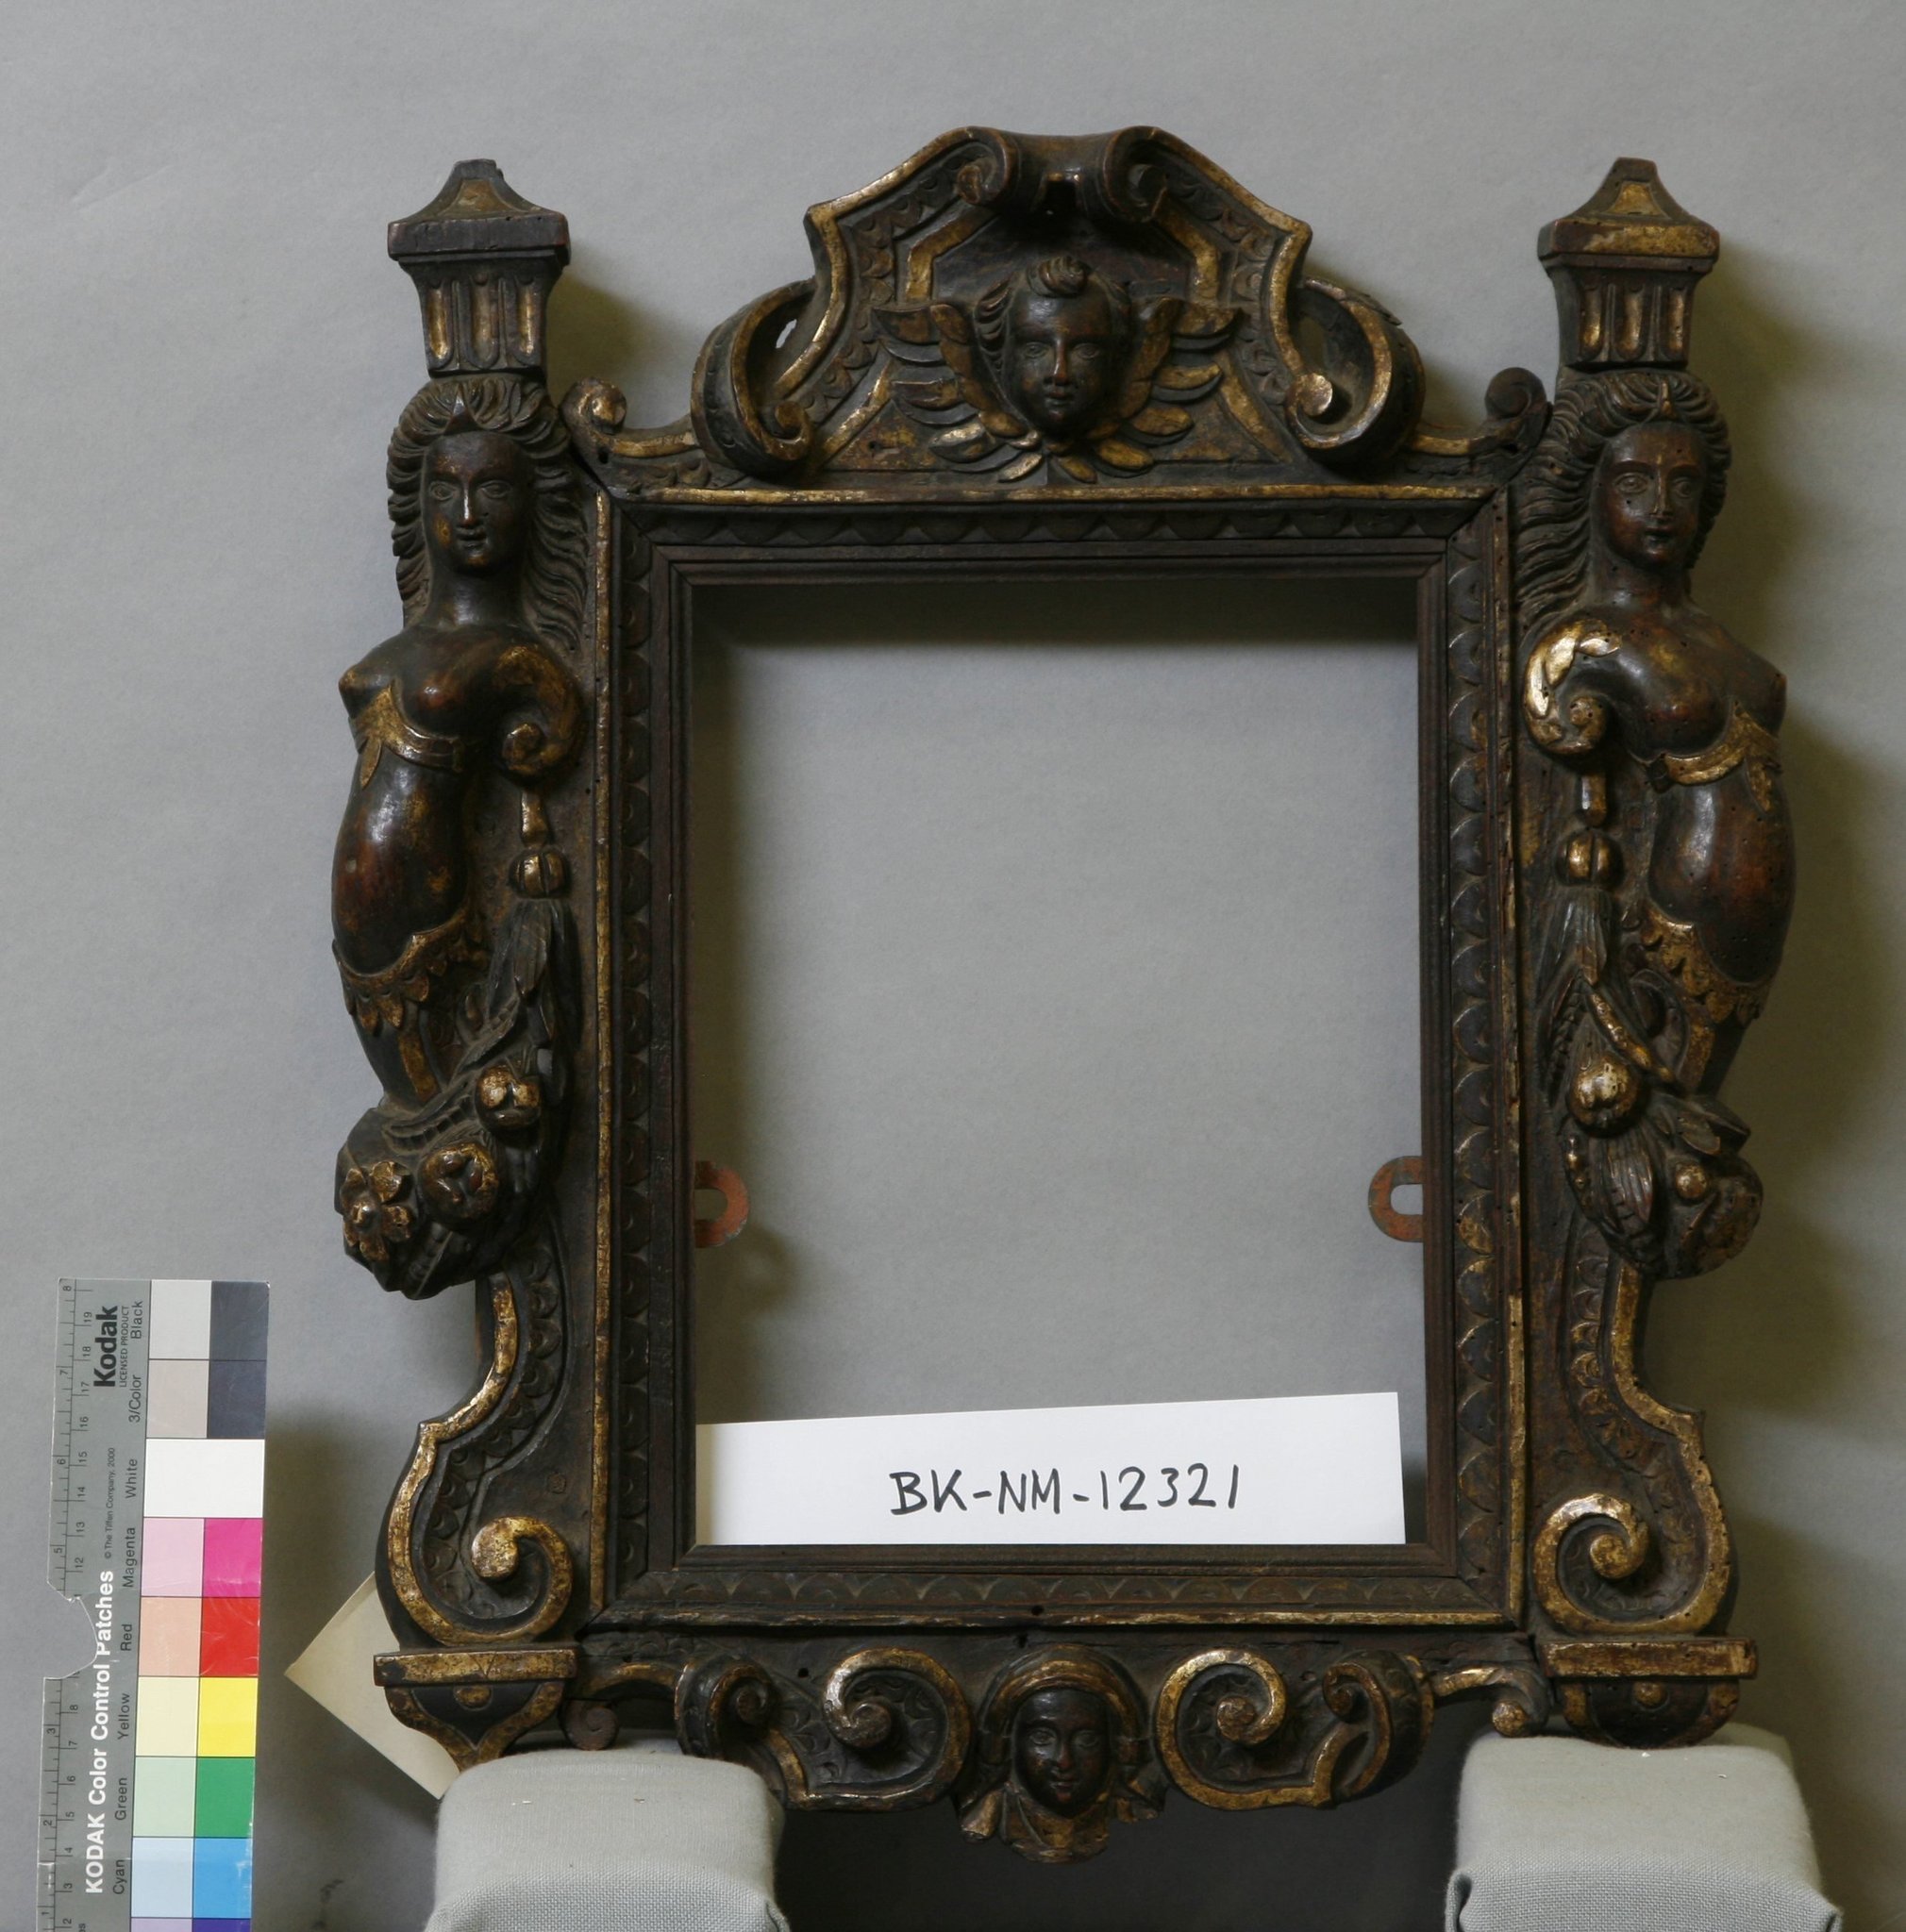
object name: frame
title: Spiegel- of schilderijlijst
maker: Anonymous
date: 1550-1615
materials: gold leaf, wood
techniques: cutting, gilding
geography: france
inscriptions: label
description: Spiegel- of schilderijlijst van notenhout met vergulde delen. De stijlen van de buitenrand vertonen kariatiden getooid met festoenen, wier onderlichamen in een voluut eindigen. Op het hoofd dragen zij een soort bouwwerk. De onderregel is versierd met een meisjeskop, getooid met een hoofddoek, te midden van voluten. Op de bovenregel een fronton opgebouwd uit voluten, waarbinnen een cherubkop. De nieuwe zool heeft een lipverbinding en er zijn ijzeren beugels aangebracht, met schroeven, op de stijlen. De conditie is goed, al zijn er houtwormgaatjes zichtbaar.